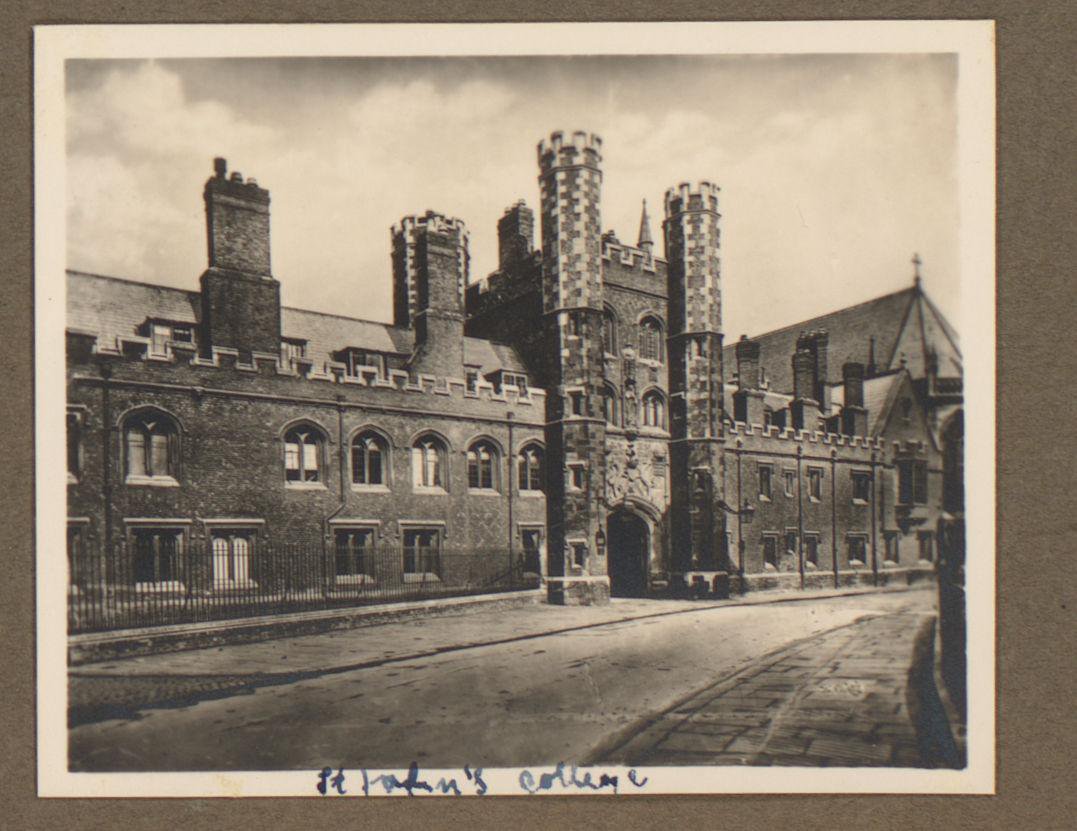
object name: photograph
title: St. John's College, Cambridge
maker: Anonymous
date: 1932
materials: paper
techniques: gelatin silver print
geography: cambridge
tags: university building, college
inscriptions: inscription: ‘St. John's College’